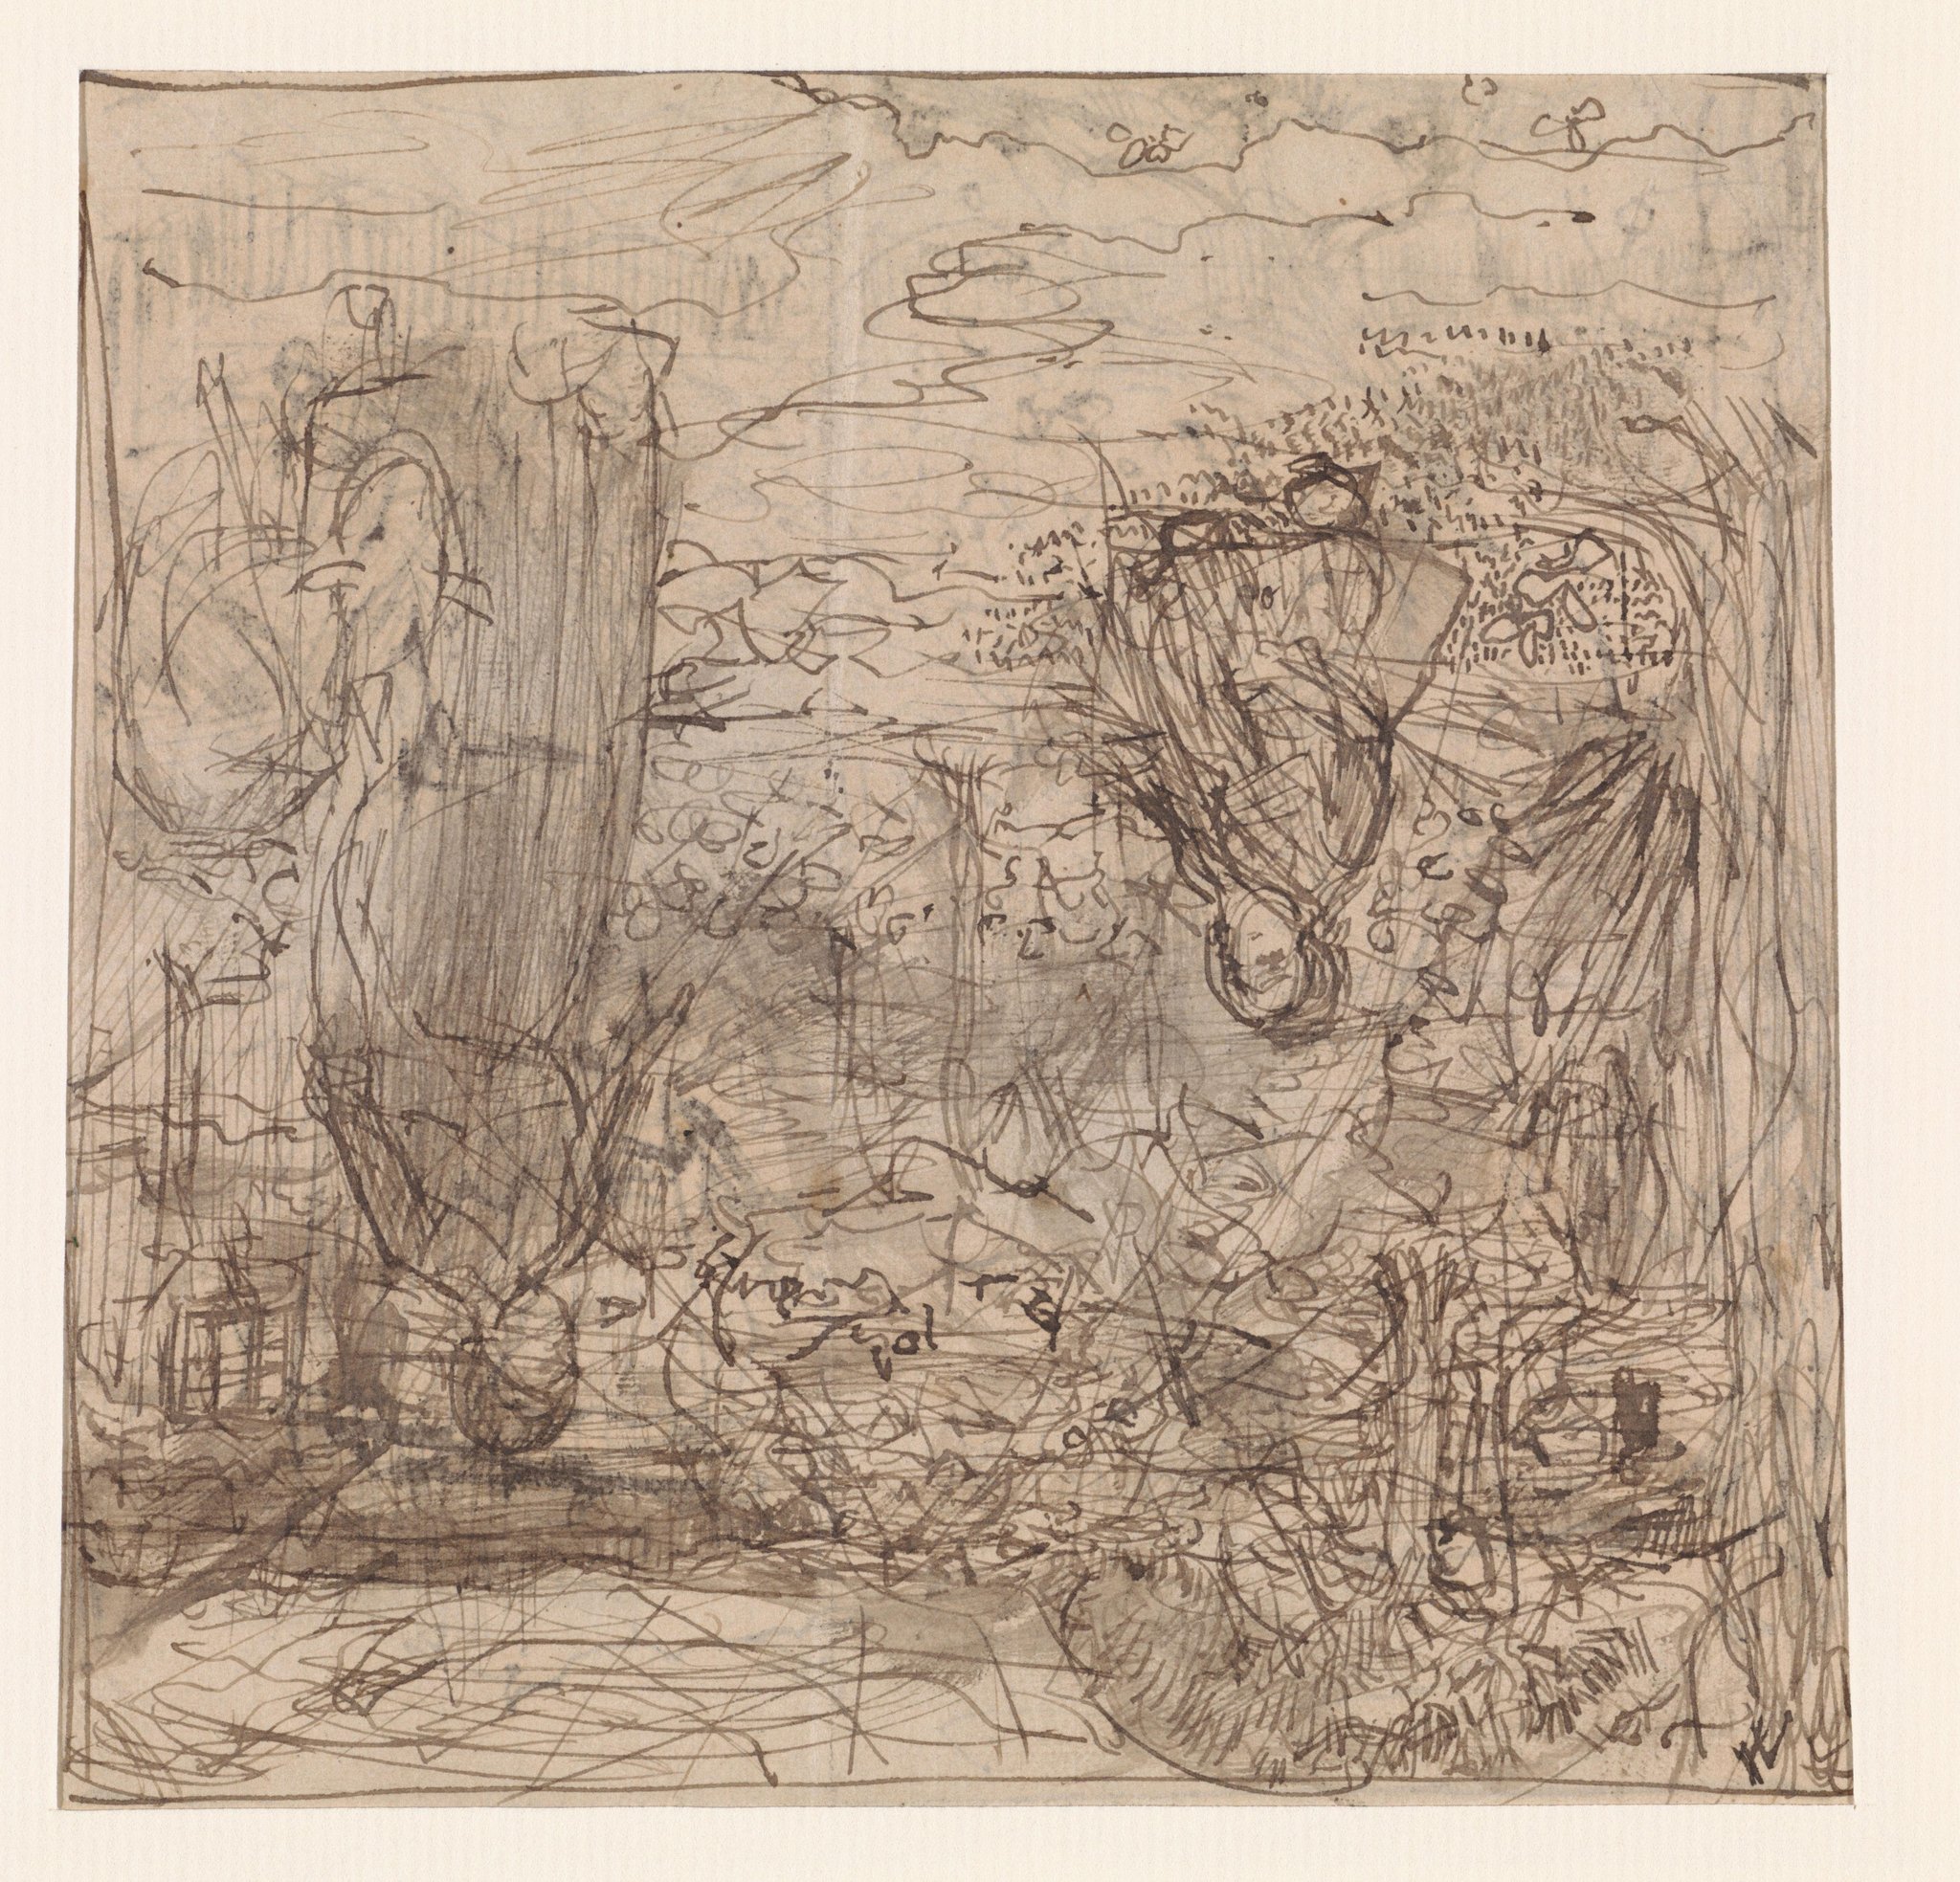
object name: drawing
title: Moeder met kind in een tuin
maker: edzard koning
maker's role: draughtsman, print maker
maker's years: 1869-1954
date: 1879-1954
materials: ink, paper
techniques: pen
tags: garden, mother and baby or young child